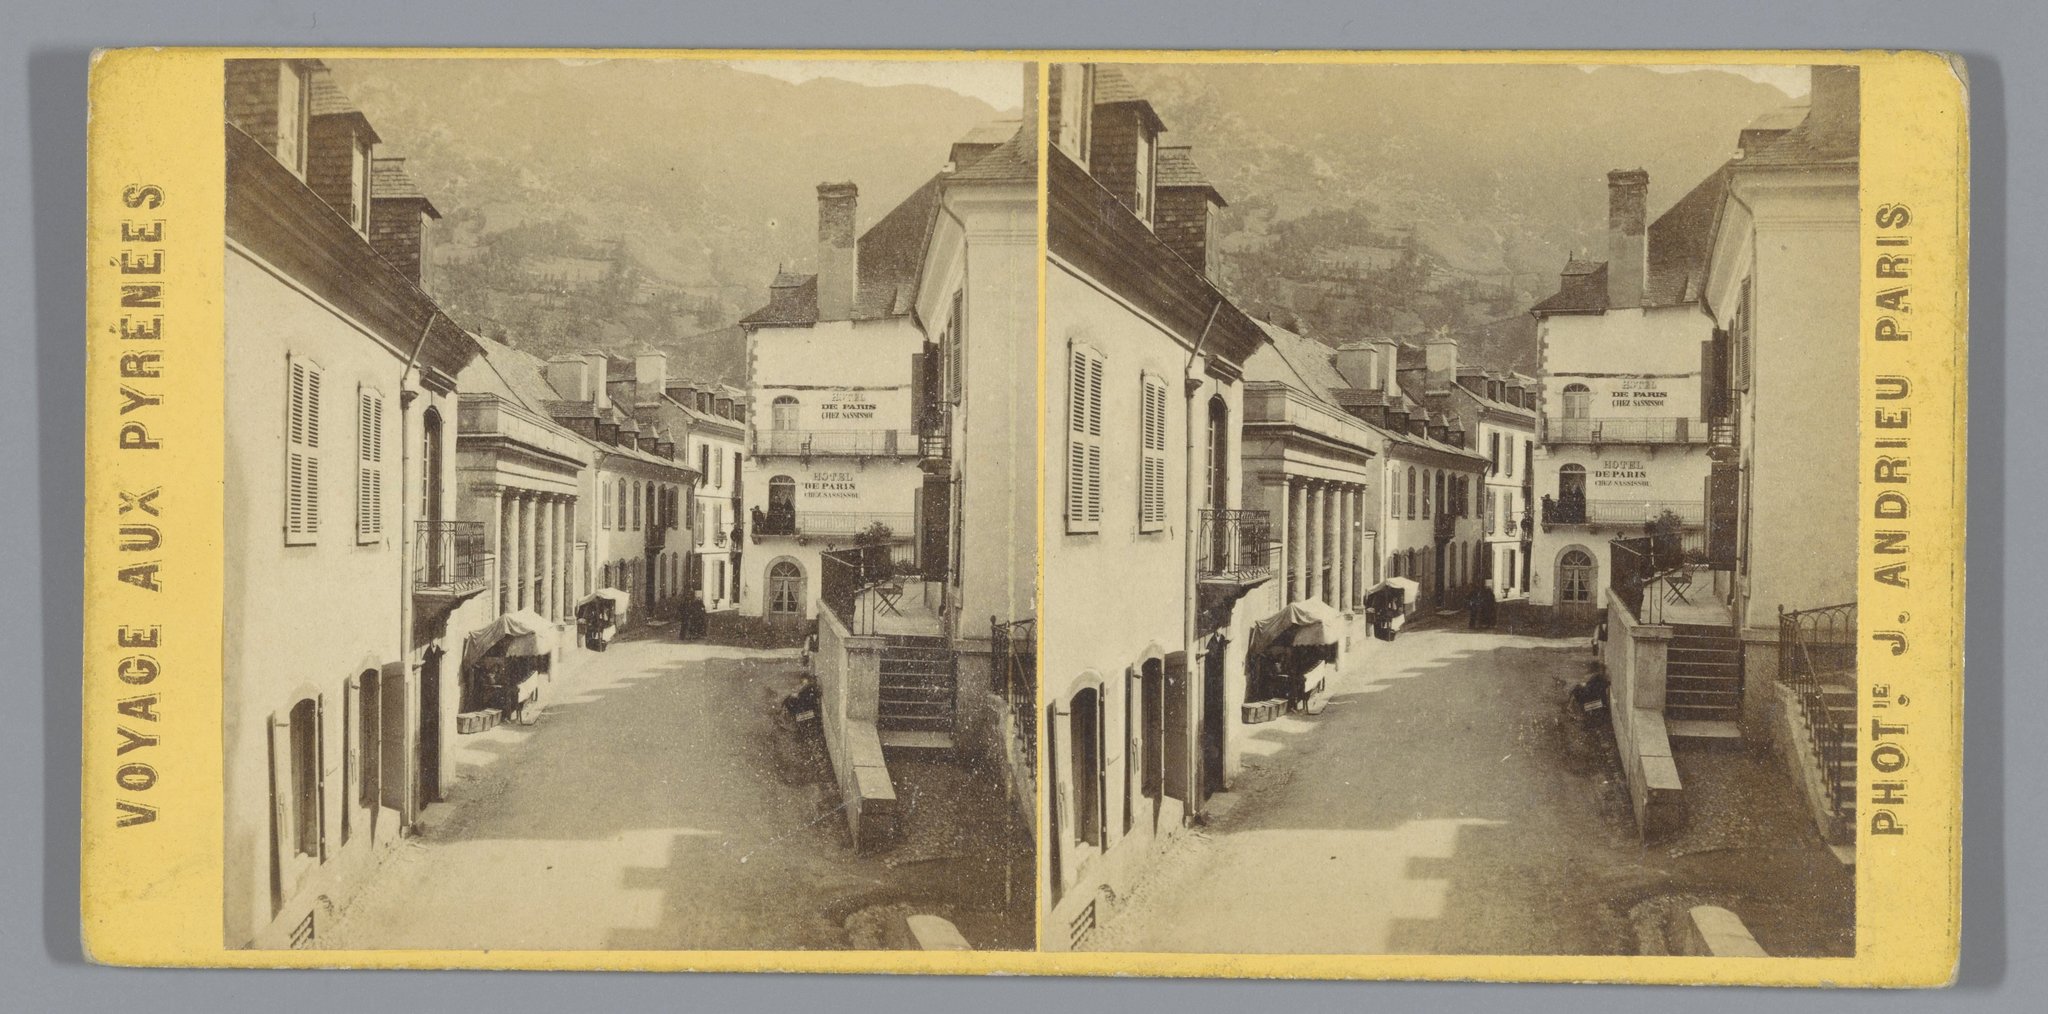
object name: stereograph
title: Gezicht op een straat te Luz-Saint-Sauveur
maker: jean andrieu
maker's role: fotograaf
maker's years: 1816-1872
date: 1862-1876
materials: cardboard, photographic support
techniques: albumen print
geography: luz-saint-sauveur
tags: street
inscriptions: number: ‘94.’, number: ‘4049’